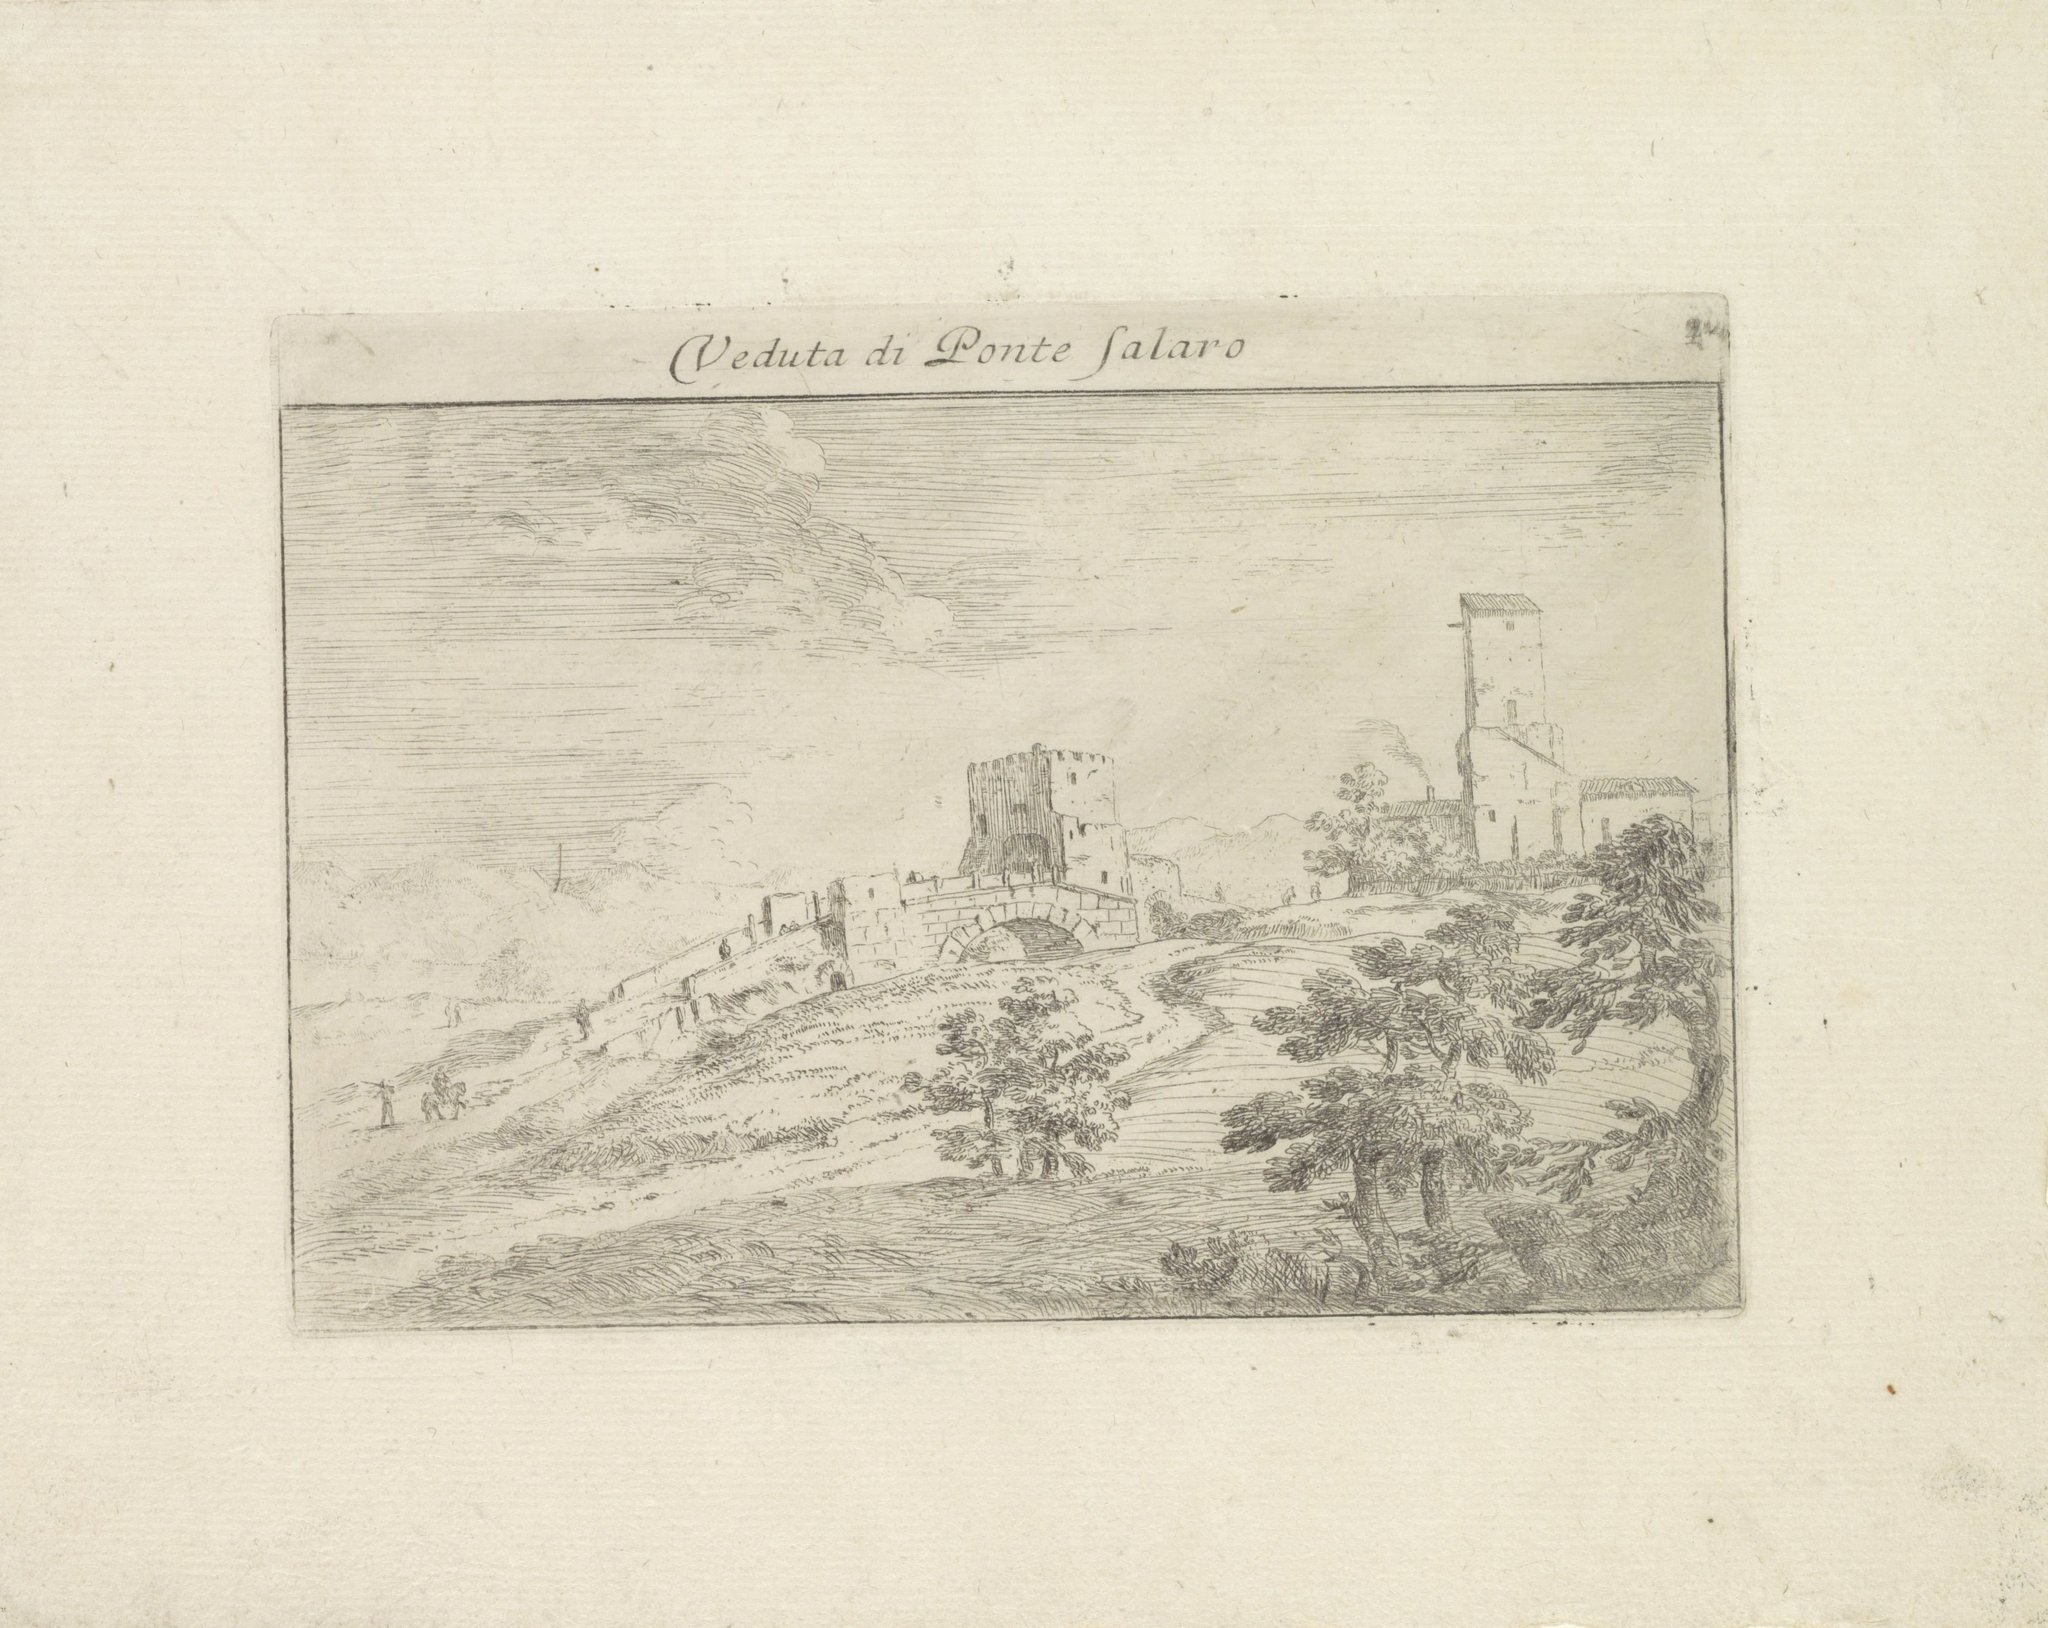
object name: print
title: Varie Vedute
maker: paolo anesi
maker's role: print maker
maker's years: 1700-1761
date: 1725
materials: paper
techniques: etching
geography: rome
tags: city-view, and landscape with man-made constructions, bridge, rome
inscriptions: collector's mark: Lugt 2760, collector's mark: Lugt 2228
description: Landschap met de Ponte Salario in Rome. Boven de voorstelling de titel. Genummerd rechtsboven: 4.